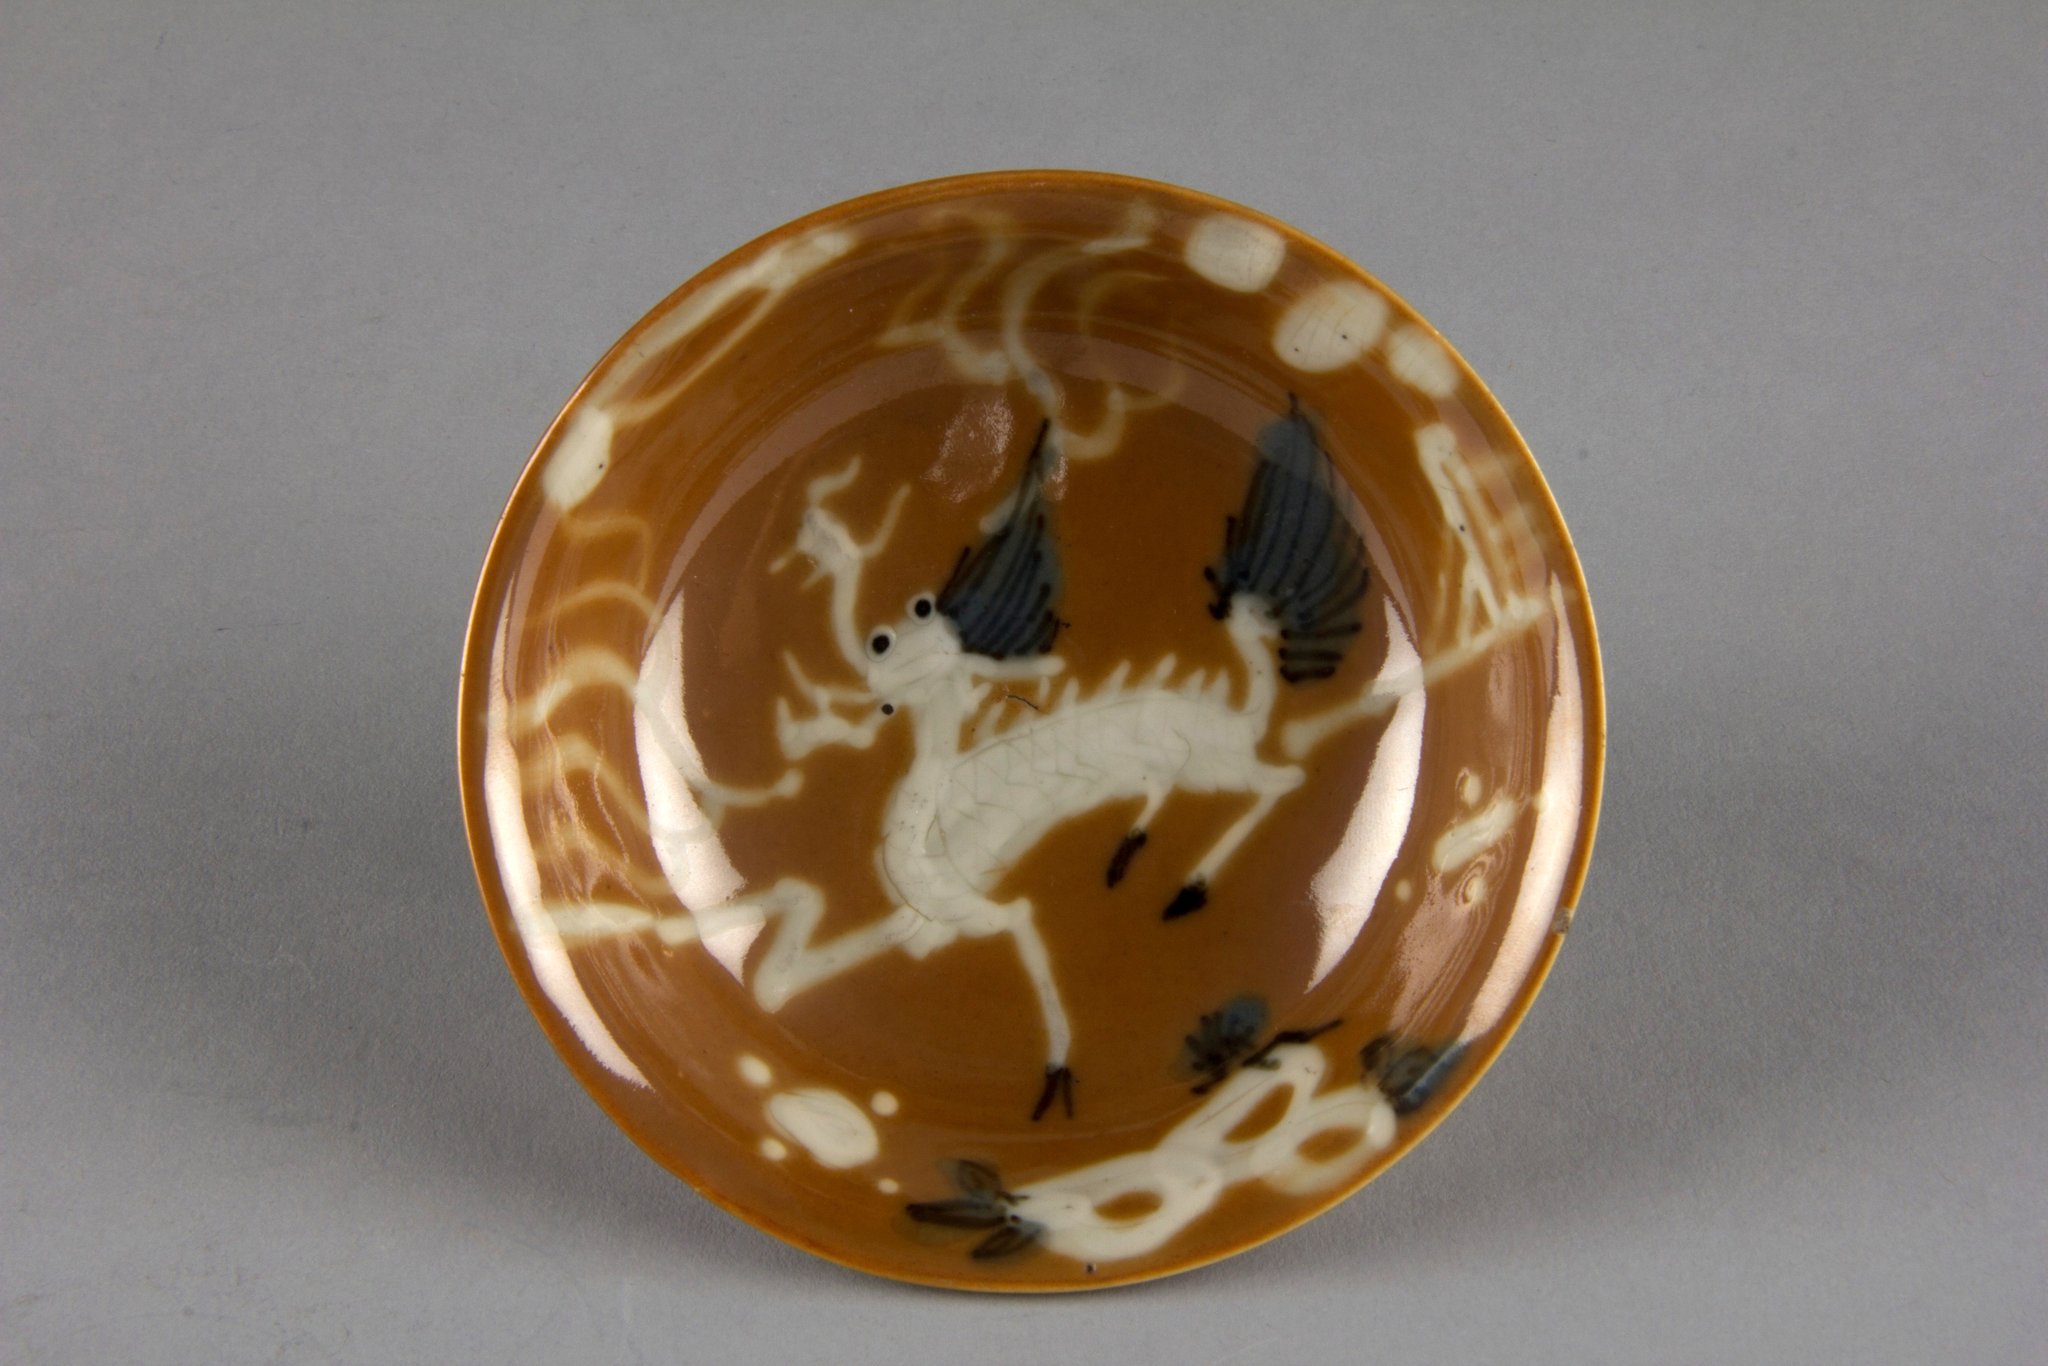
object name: dish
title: Dish with mythical beast qilin (one of a pair)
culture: chinese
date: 1567-1600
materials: glaze, porcelain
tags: mythical creatures